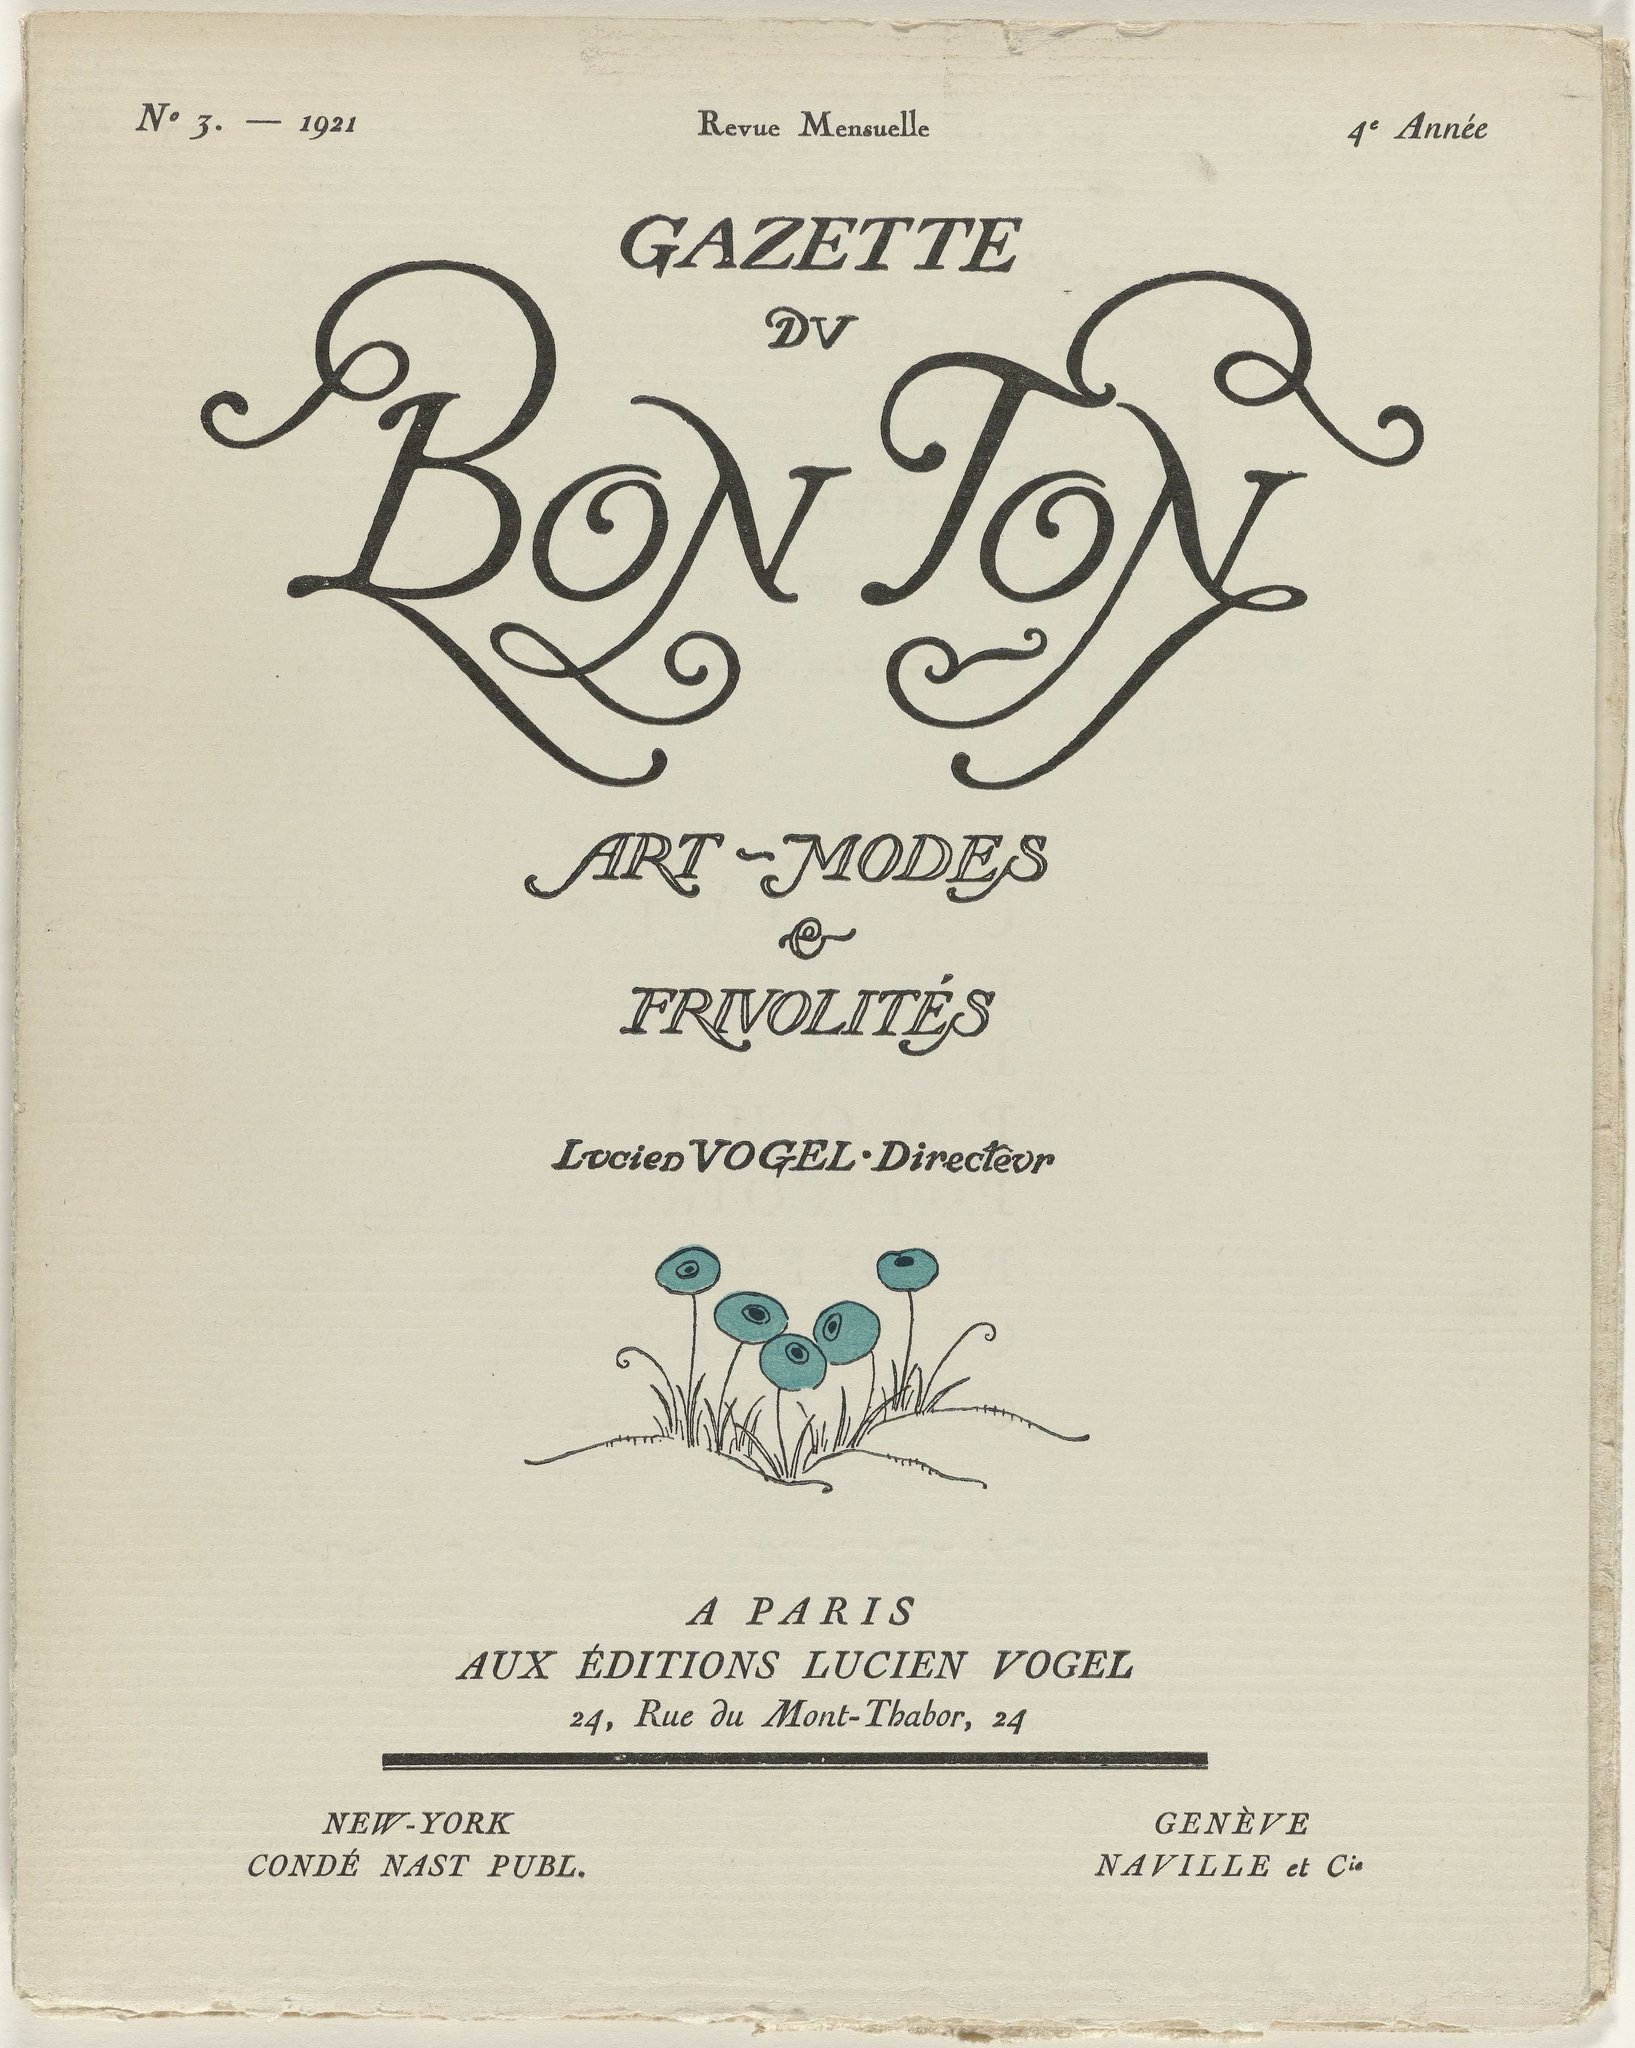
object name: magazine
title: Gazette du Bon Ton. Art - Modes & Frivolités, No. 3 - 1921, 4e Année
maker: lucien vogel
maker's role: publisher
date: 1921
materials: paper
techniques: letterpress printing, pochoir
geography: paris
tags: fashion plates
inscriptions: date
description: Aflevering no. 3, maart 1921, van Gazette du Bon Ton, bestaand uit een omslag, negen katernen met tekst en illustraties en twaalf losse prenten. Aan dit deel werkten de volgende modeontwerpers mee: Beer, Cheruit, Doeuillet, Doucet, Lanvin, Paquin, Paul Poiret, Redfern, Camille Roger en Worth.